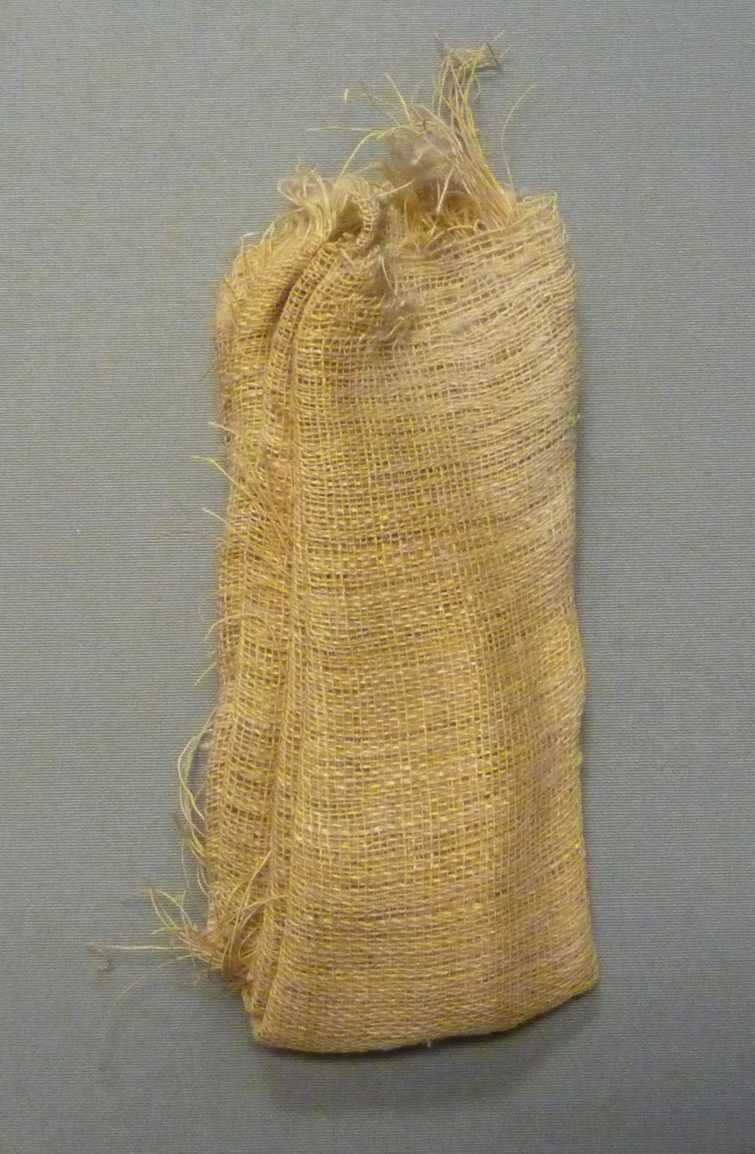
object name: linen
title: Model Sheet from a Foundation Deposit for Hatshepsut's Temple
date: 1479-1458 BCE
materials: linen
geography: egypt